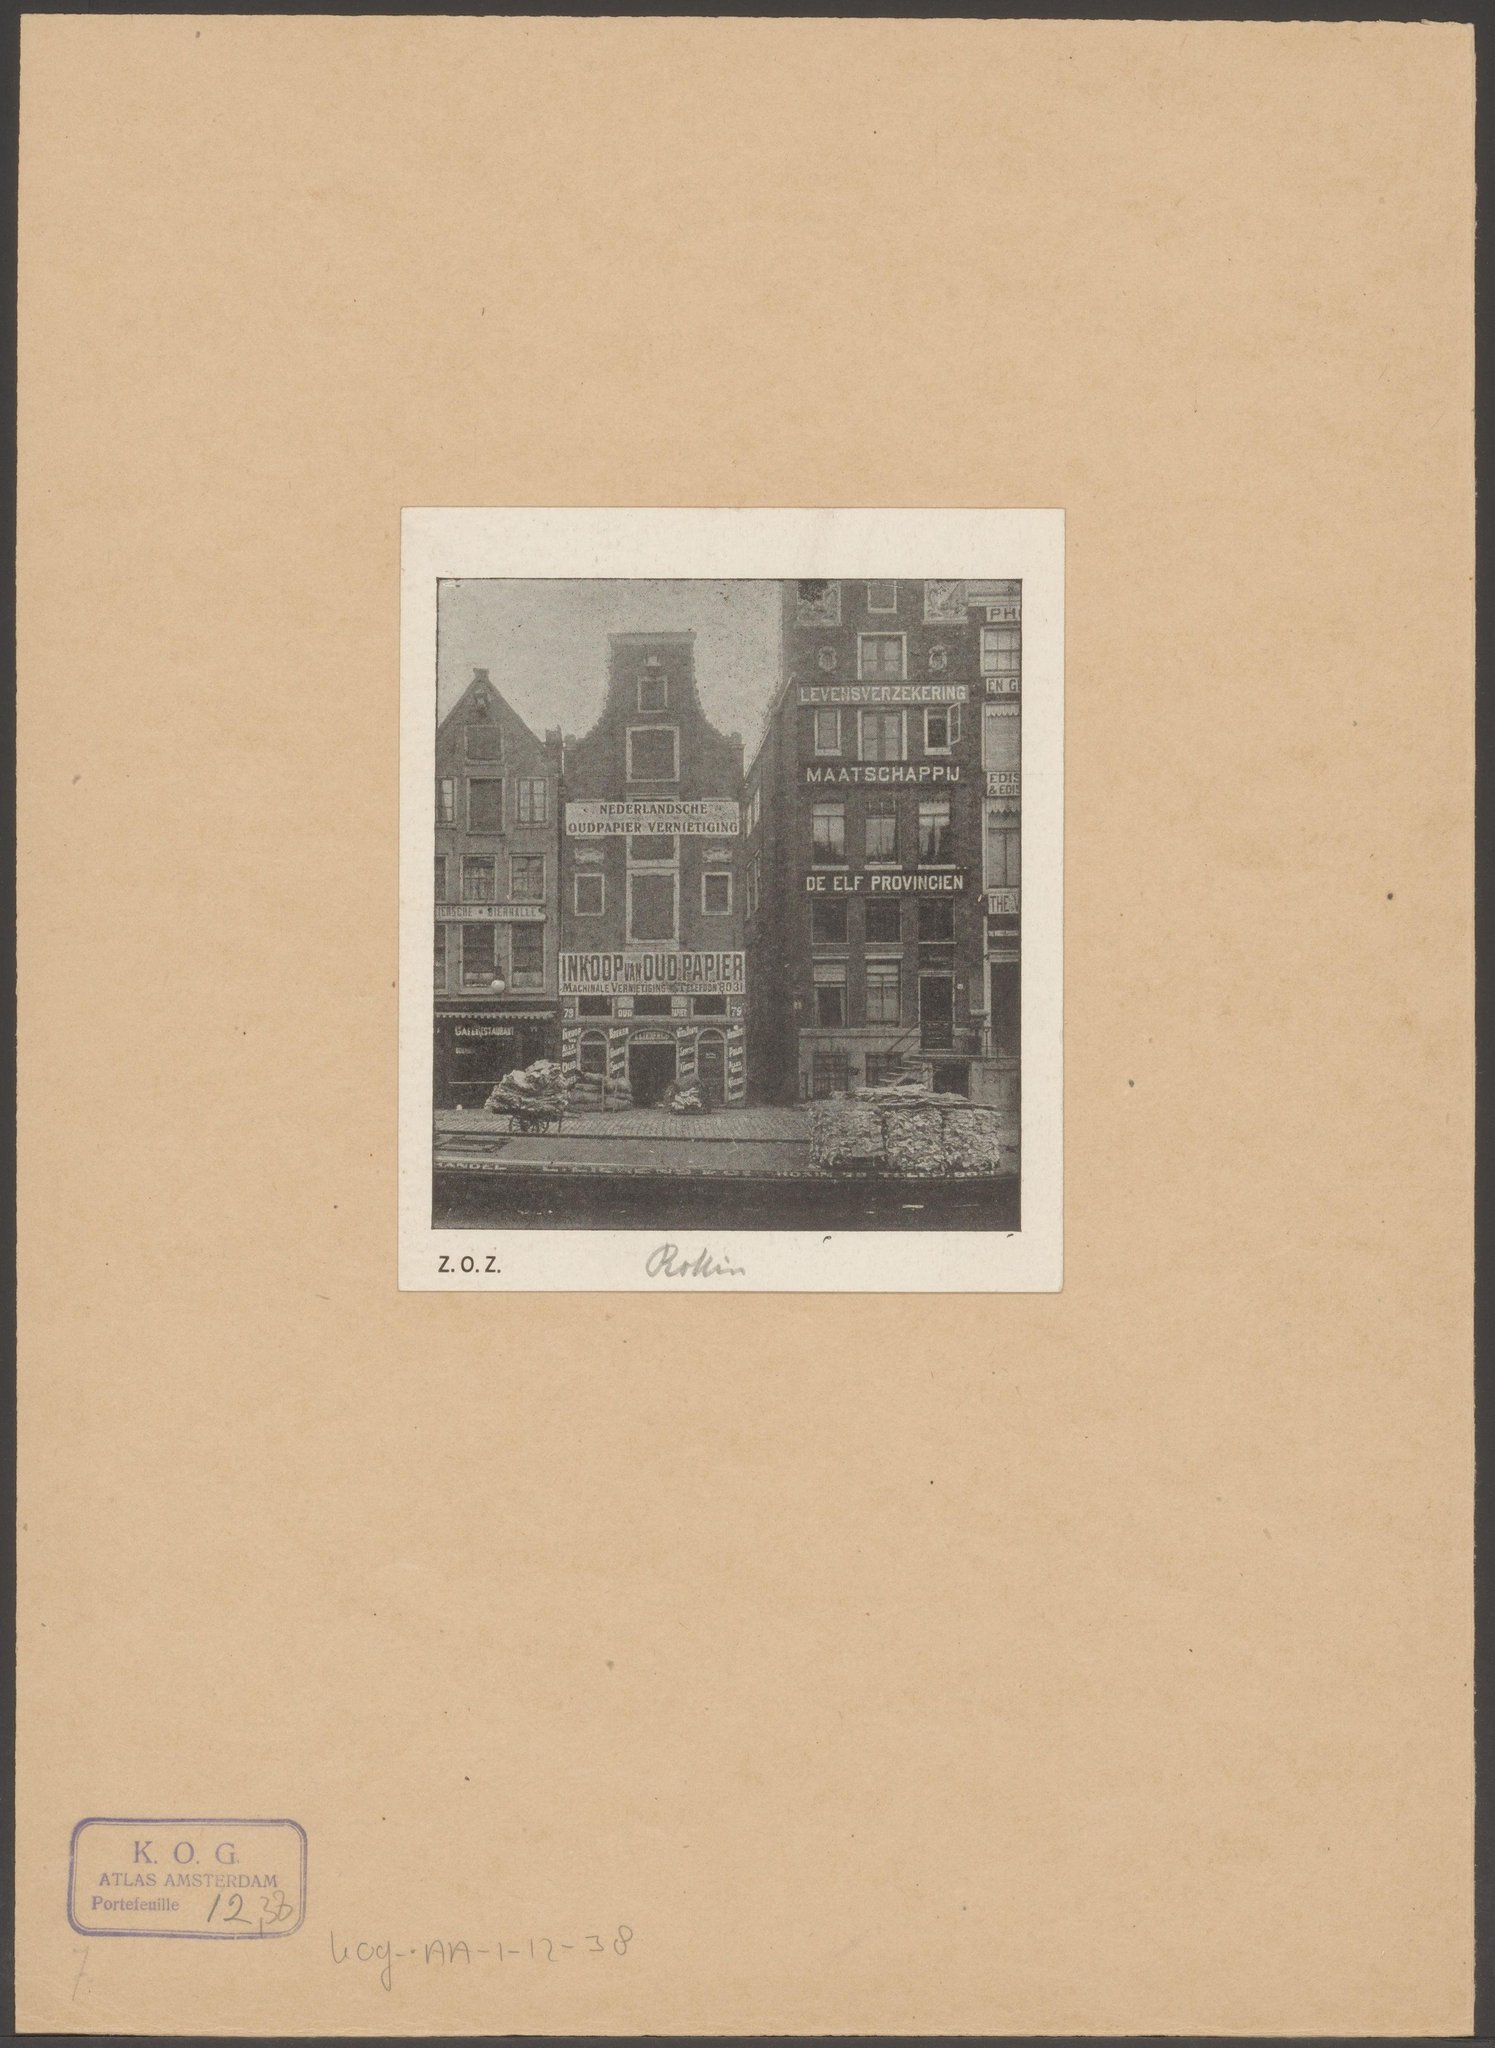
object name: advertising card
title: Reclamekaart voor het de Nederlandsche Oudpapier Vernietiging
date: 1907-1913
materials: paper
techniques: letterpress printing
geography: amsterdam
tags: city-view in general; 'veduta', façade (of house or building)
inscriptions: collector's mark: ‘12,38’ Lugt 1641b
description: Onderwerpsrubriek binnen de Atlas Amsterdam: Rokin, Rotterdammersloot, Rozengang, Rozengracht, Rozenstraat, Rusland, Rustenburgerstraat, Ruysdaelkade, Ruysdaelstraat, Ruyterkade (de), Ruyterweg (Admiraal de).